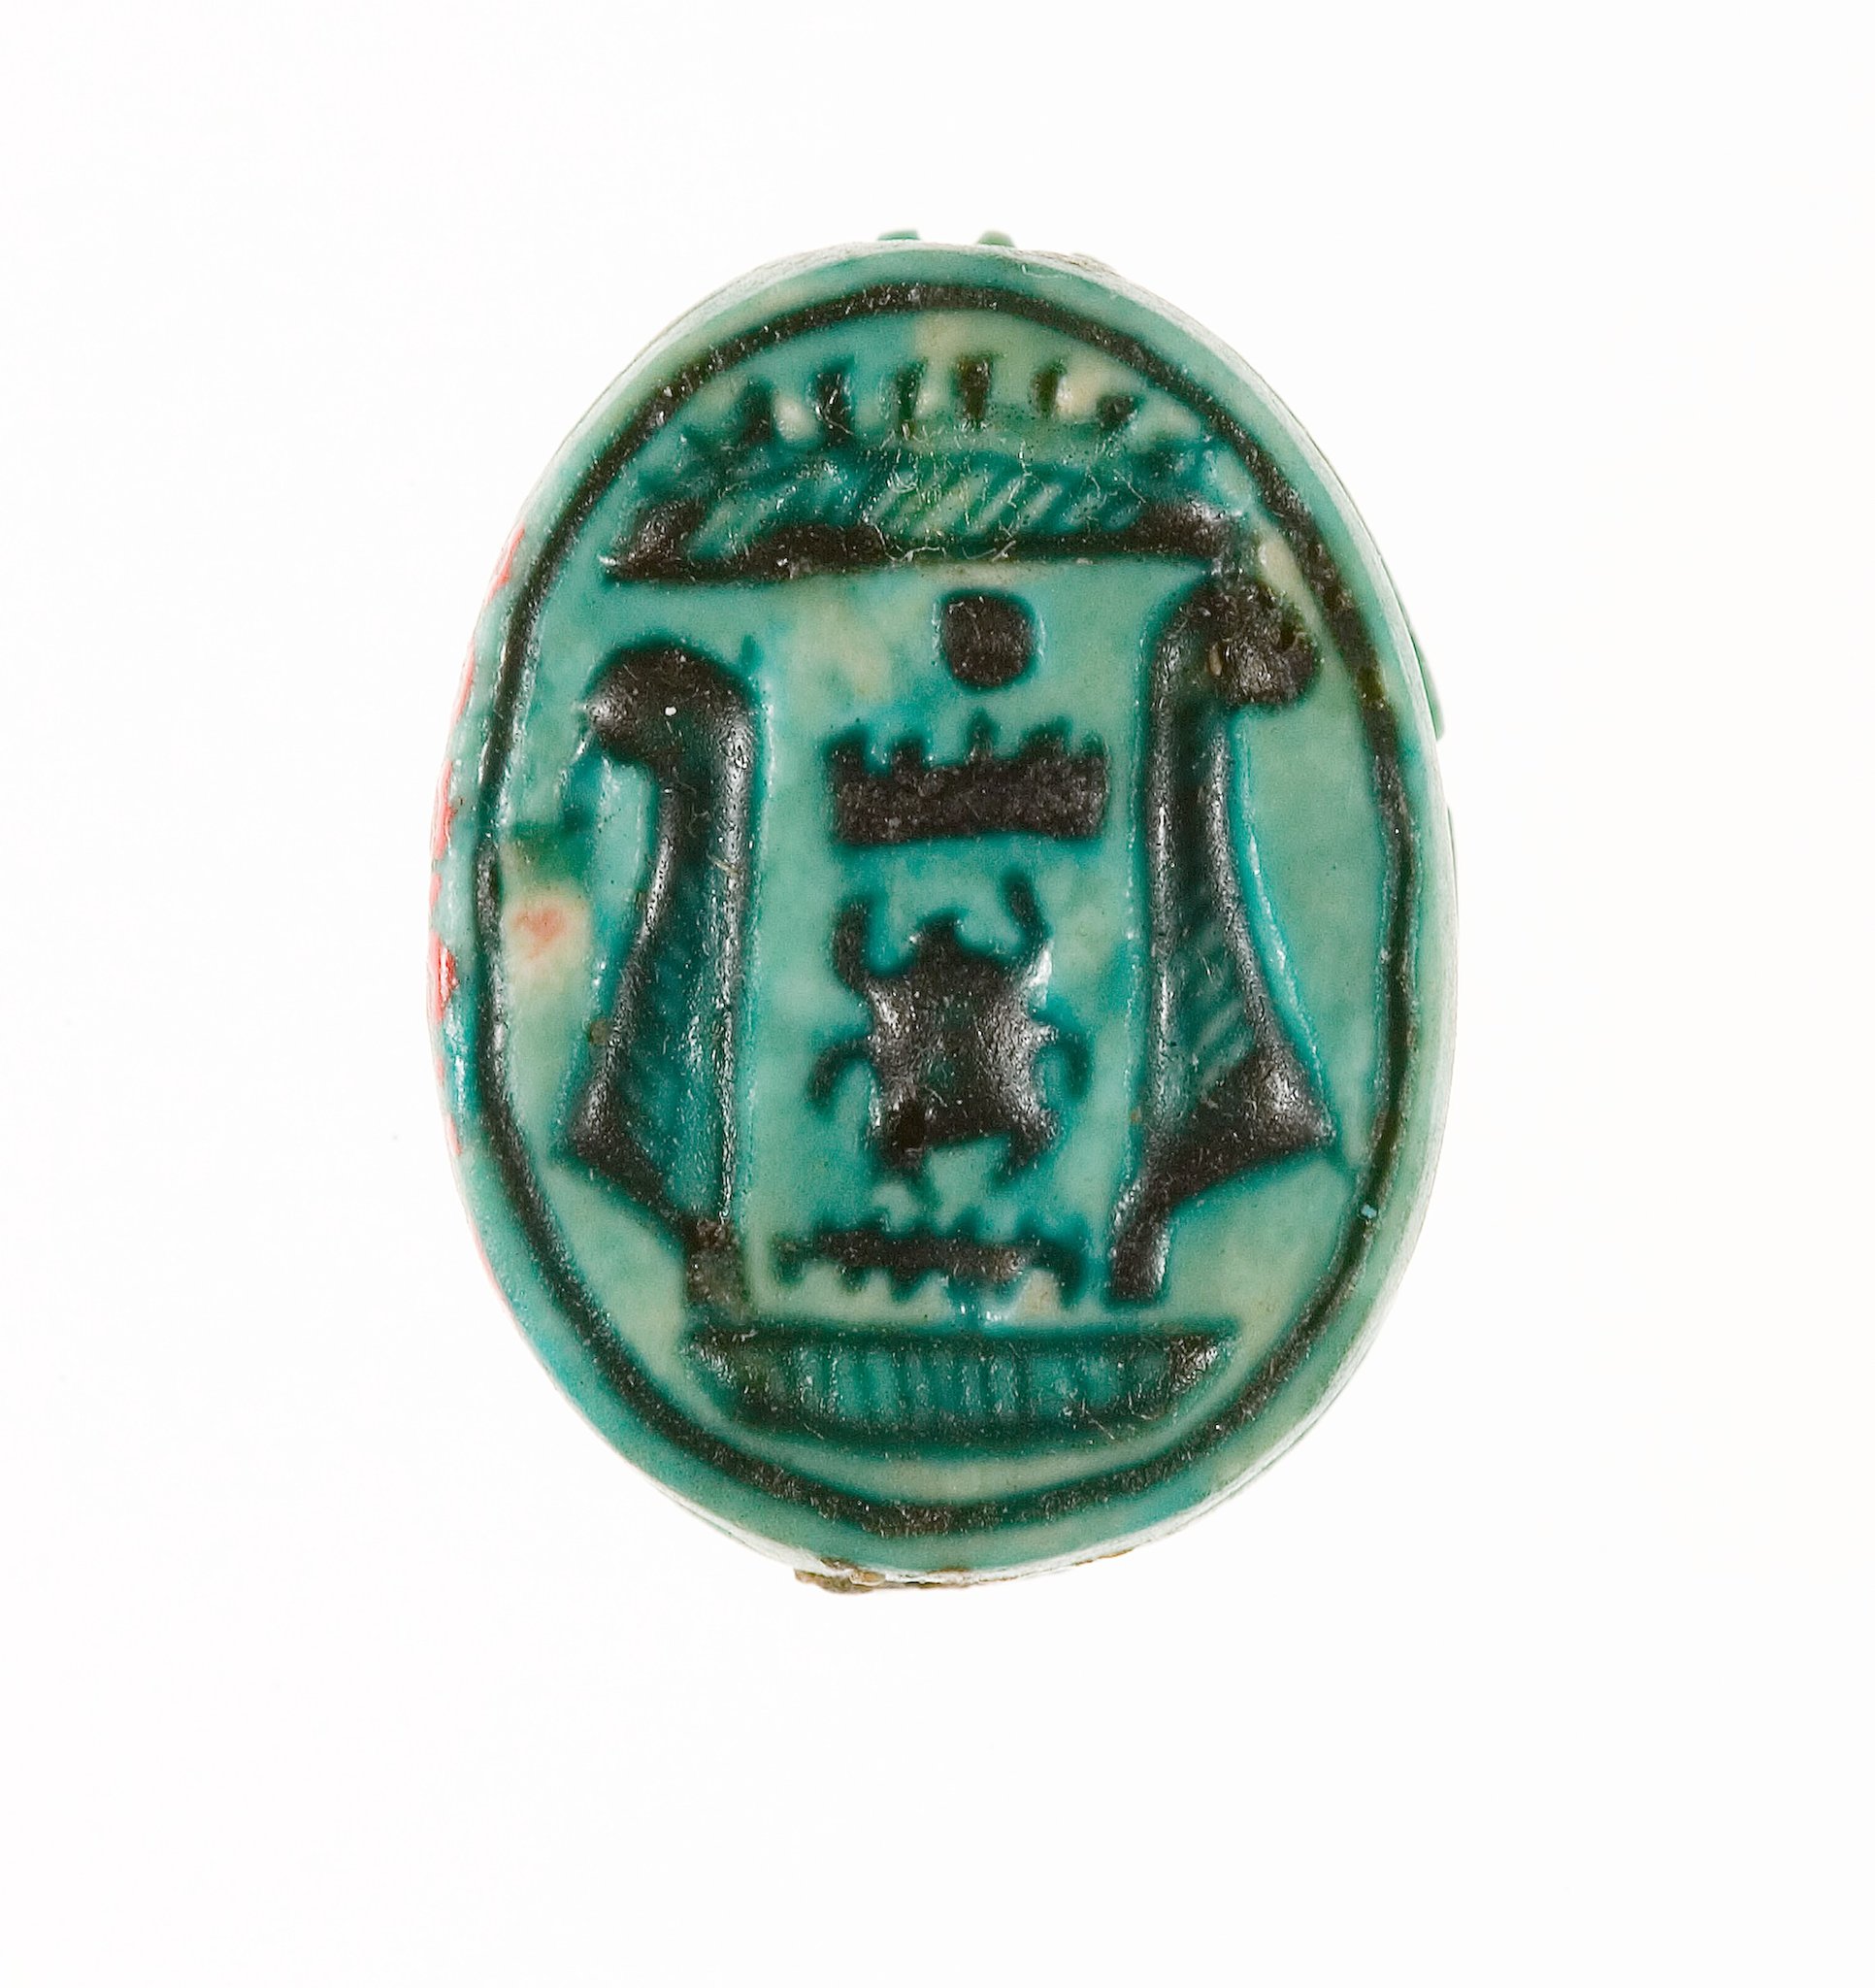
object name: scarab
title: Scarab Inscribed with the Throne Name of Thutmose III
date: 1479-1458 BCE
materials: stone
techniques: glazing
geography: egypt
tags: hieroglyphs,scarabs